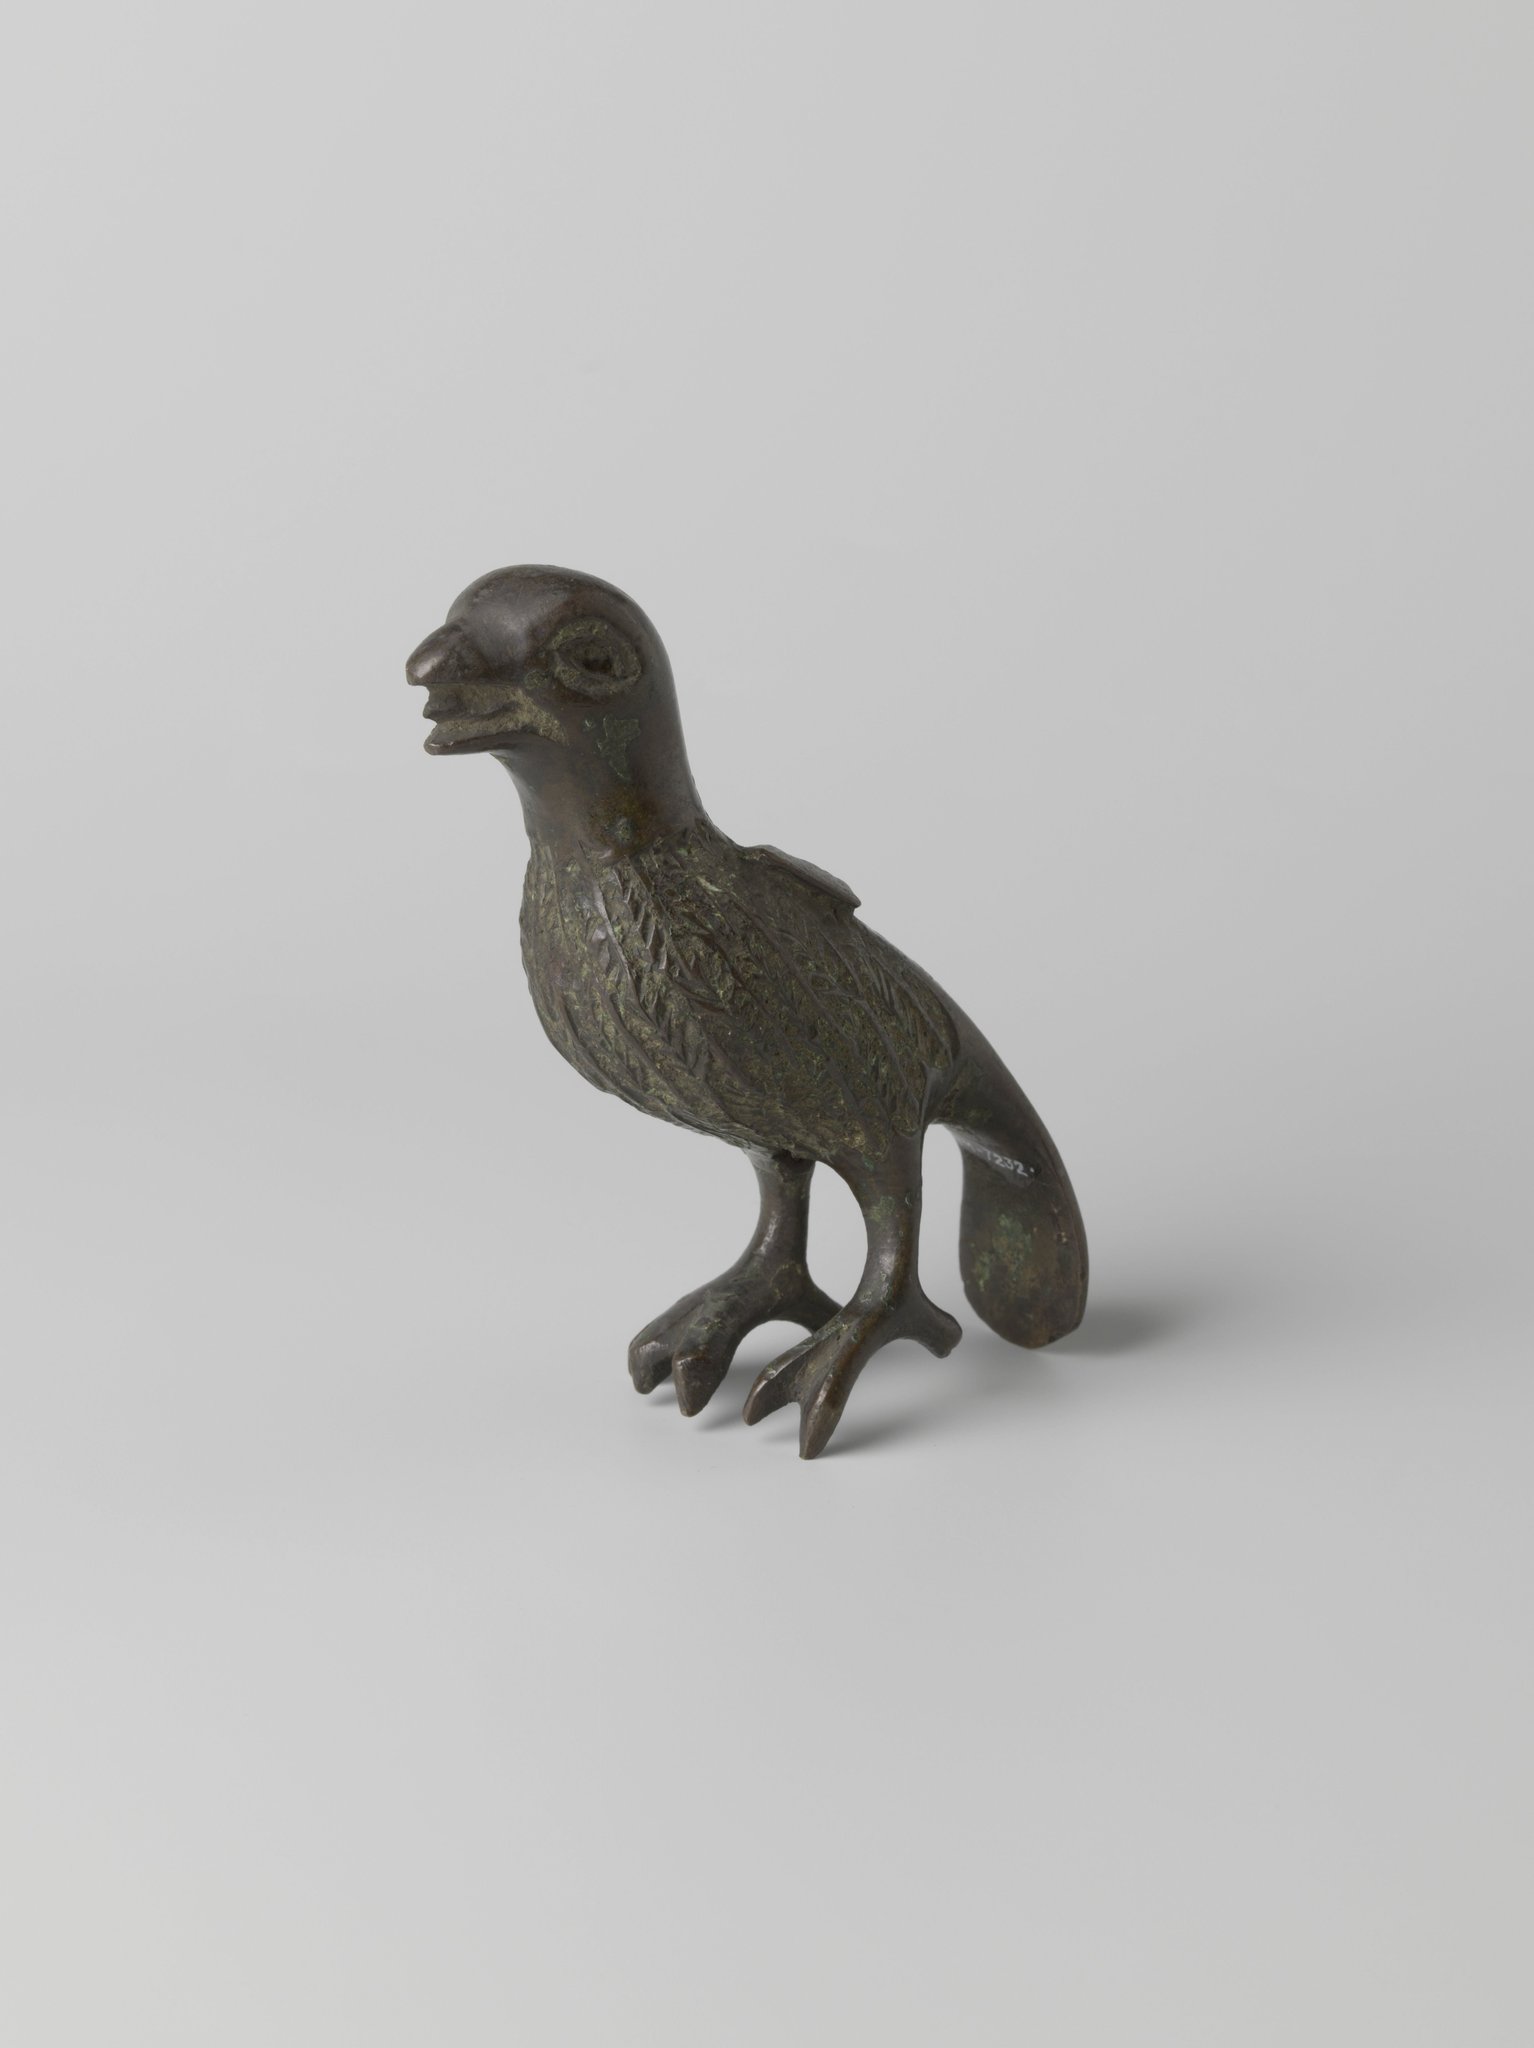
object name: chandelier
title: Vogel (onderdeel van een kaarsenkroon)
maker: Anonymous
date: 1400-1500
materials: brass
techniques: casting, metalworking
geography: southern netherlands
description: Het voorwerp is gegoten.De ogen, de geopende bek en de borstveren zijn bijgeciseleerd. Eén poot heeft twee voortenen, de andere drie. De vleugels ontbreken. Het is hol en onder- en bovenaan voorzien van een opening.